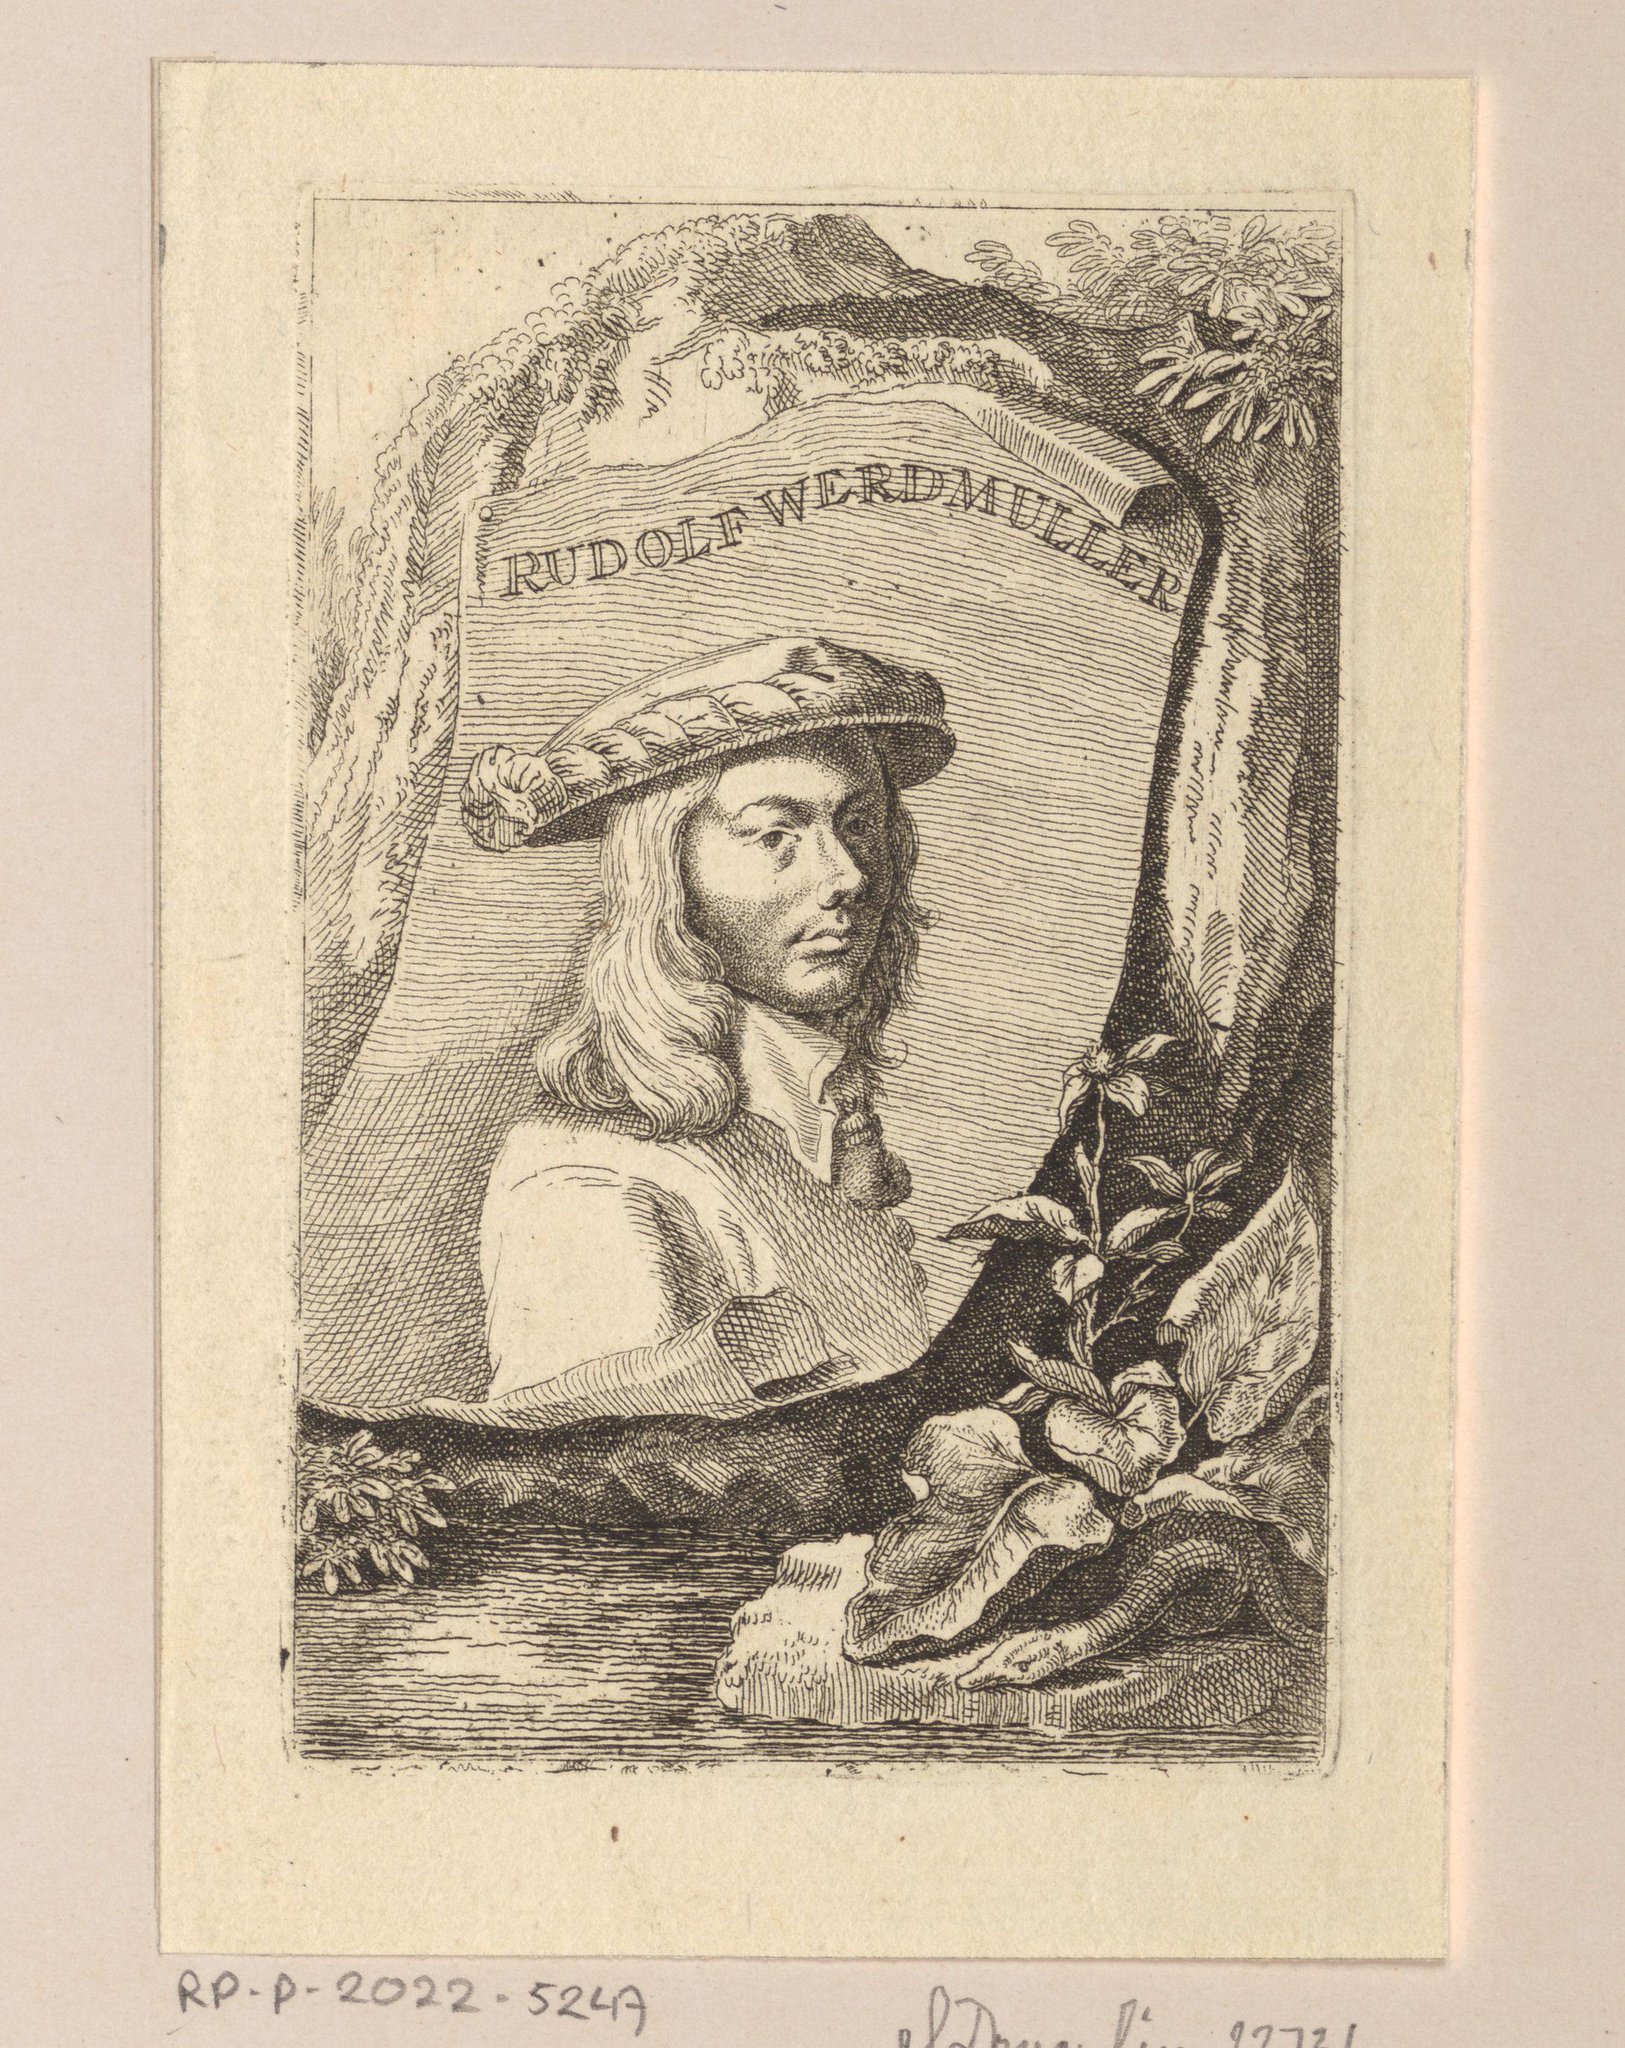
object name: print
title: Portret van Johann Rudolf Werdmüller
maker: rudolf füssli (der jüngste)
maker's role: print maker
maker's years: 1737-1806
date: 1755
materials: paper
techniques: etching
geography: switzerland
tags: painter, historical persons, portrait, self-portrait of painter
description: Prent waarschijnlijk uit: Füssli, Johann Caspar. Geschichte und Abbildung der besten Mahlern in der Schweitz. Zürich: David Gessner, 1755, dl. 1.